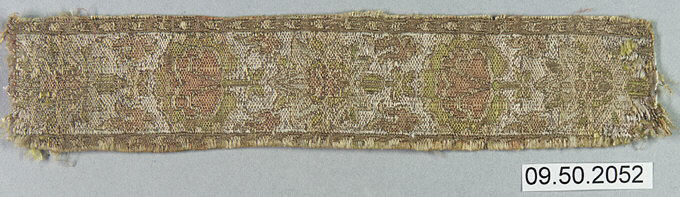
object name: band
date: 1601-1800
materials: linen, metal thread, silk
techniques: brocade, weave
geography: iran